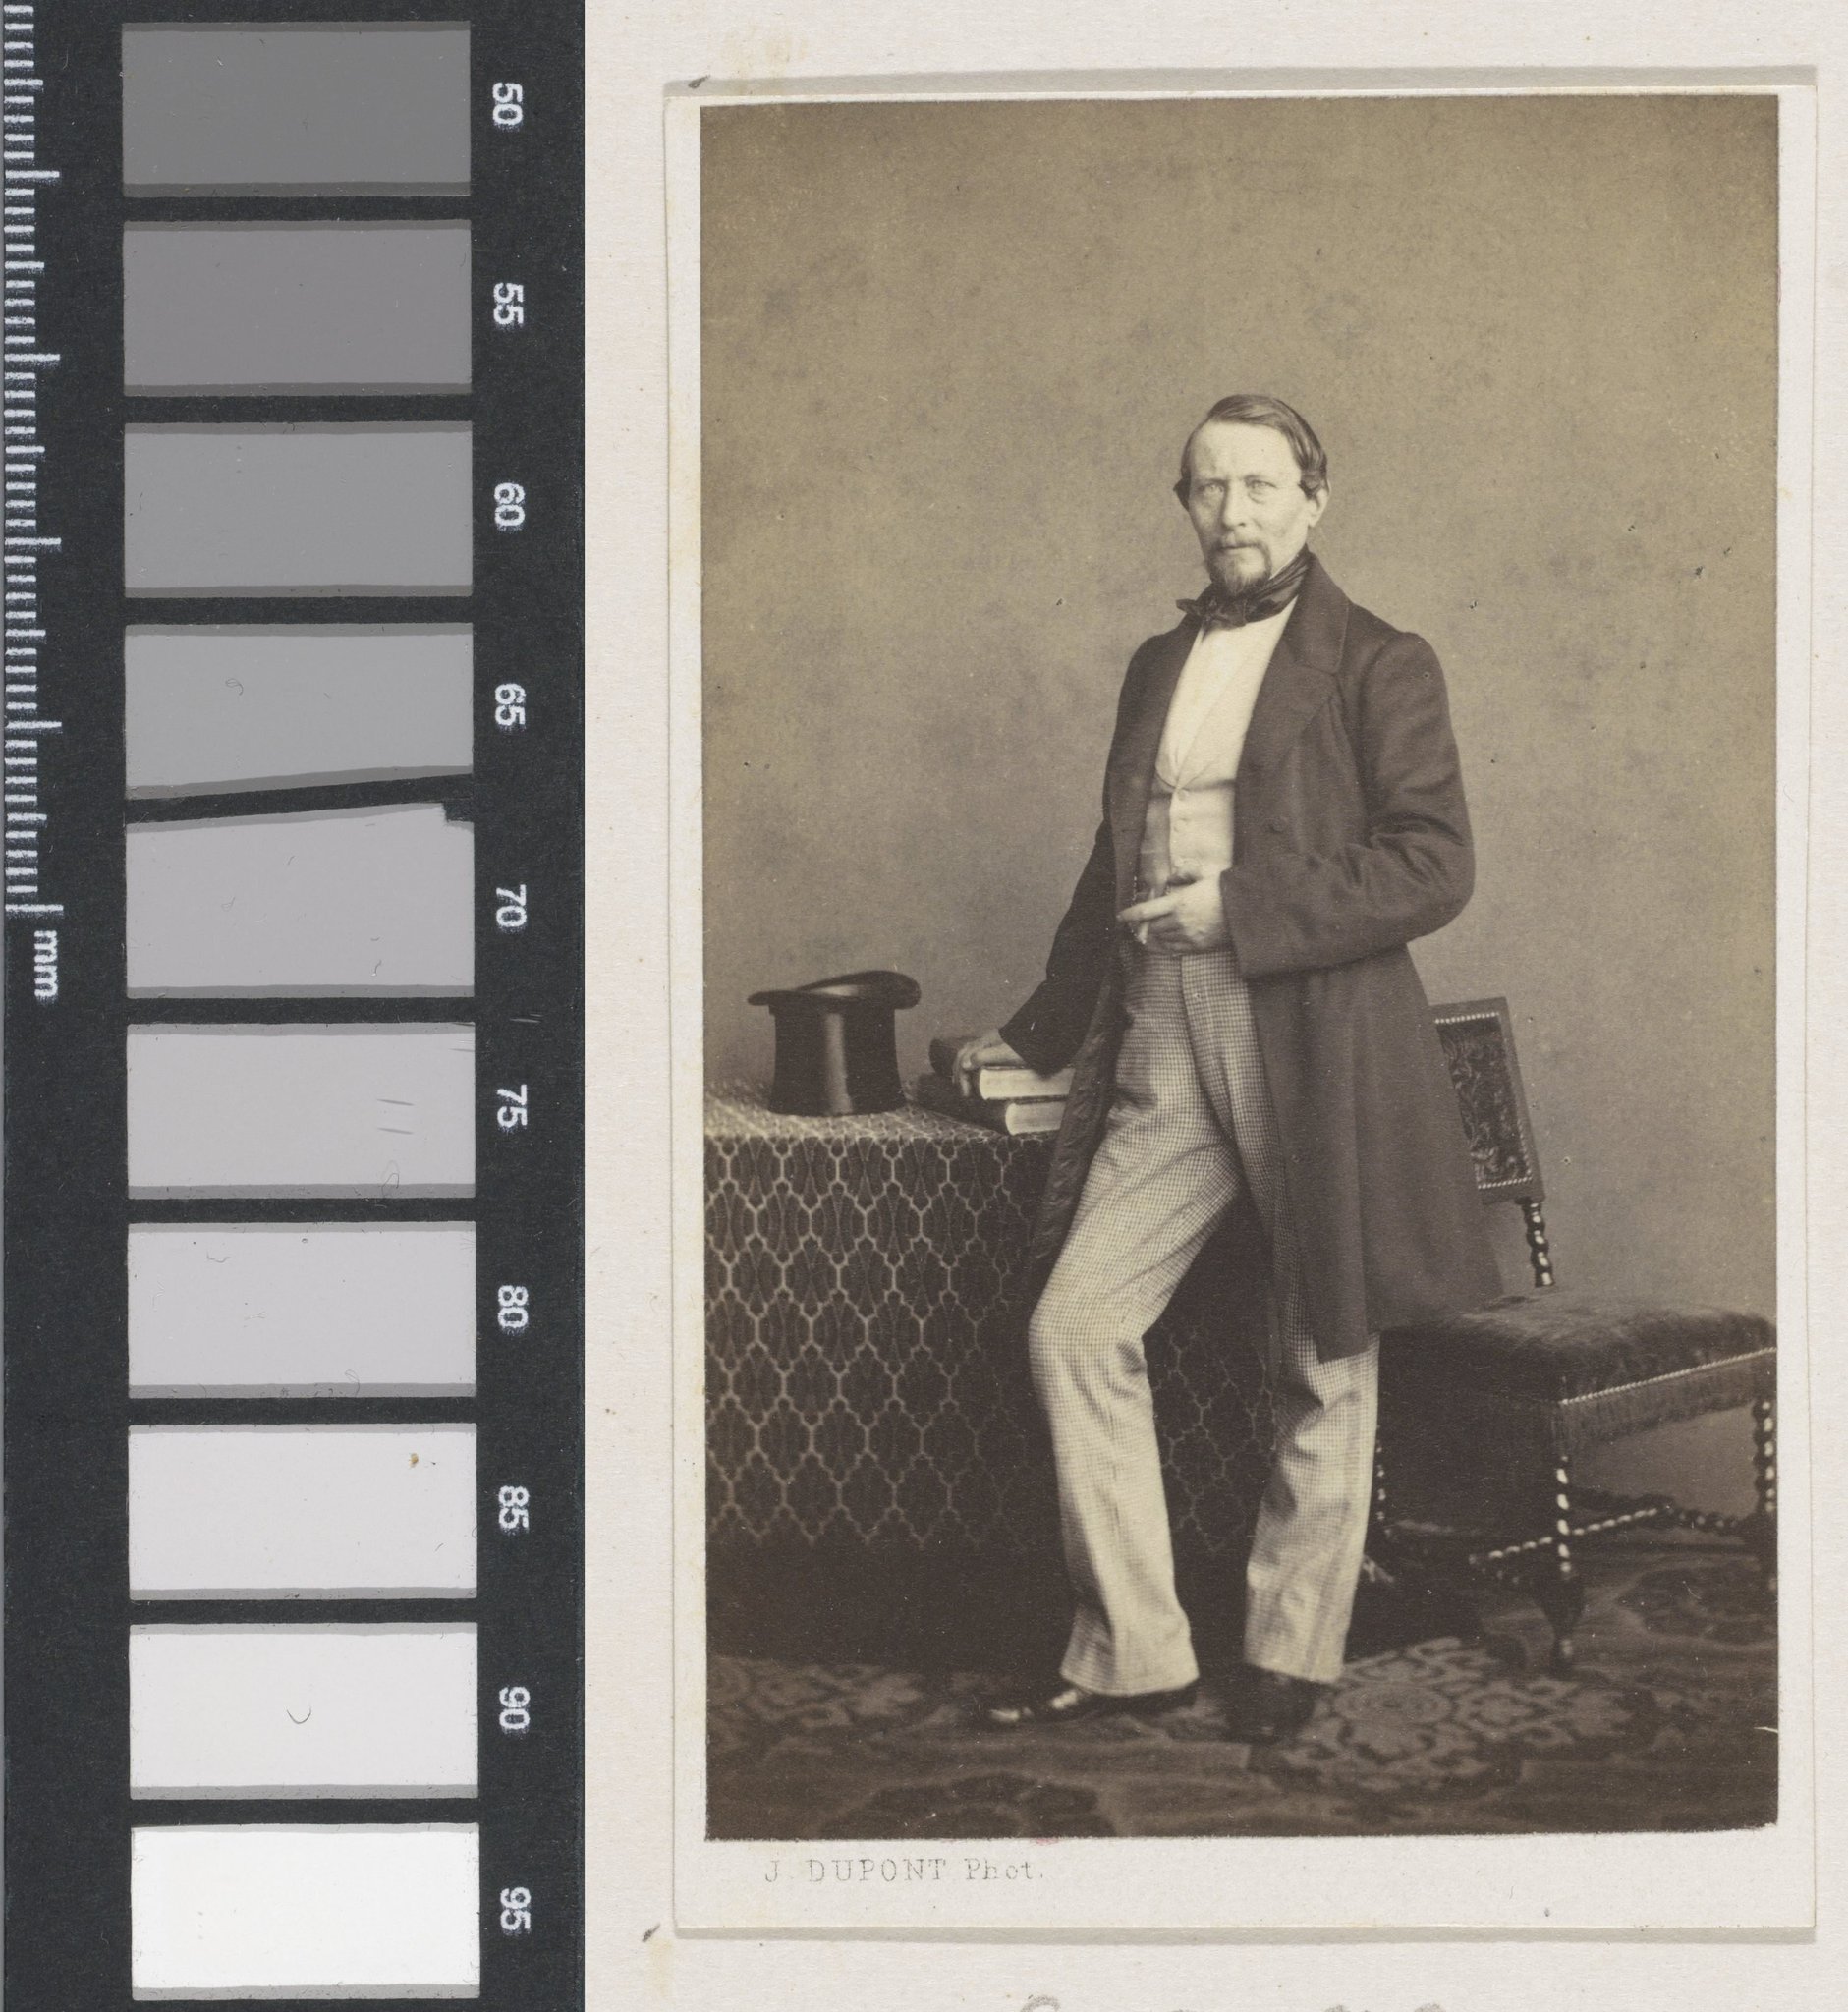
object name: carte de visite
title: L'École d'Anvers. Portraits biographies cartes de visite. Collection Dupont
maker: joseph dupont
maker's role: fotograaf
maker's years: 1818-1901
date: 1861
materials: cardboard, paper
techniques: albumen print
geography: antwerp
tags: antwerp, print maker, draughtsman, jean michel ruyten, historical persons, portrait, self-portrait of painter, portrait, self-portrait of artist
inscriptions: inscription: ‘ETABLISSEMENT PHOTOGRAPHIQUE/ de/ J. DUPONT/ Place de Meir 32/ ANVERS/ Maison fondée en 1853’